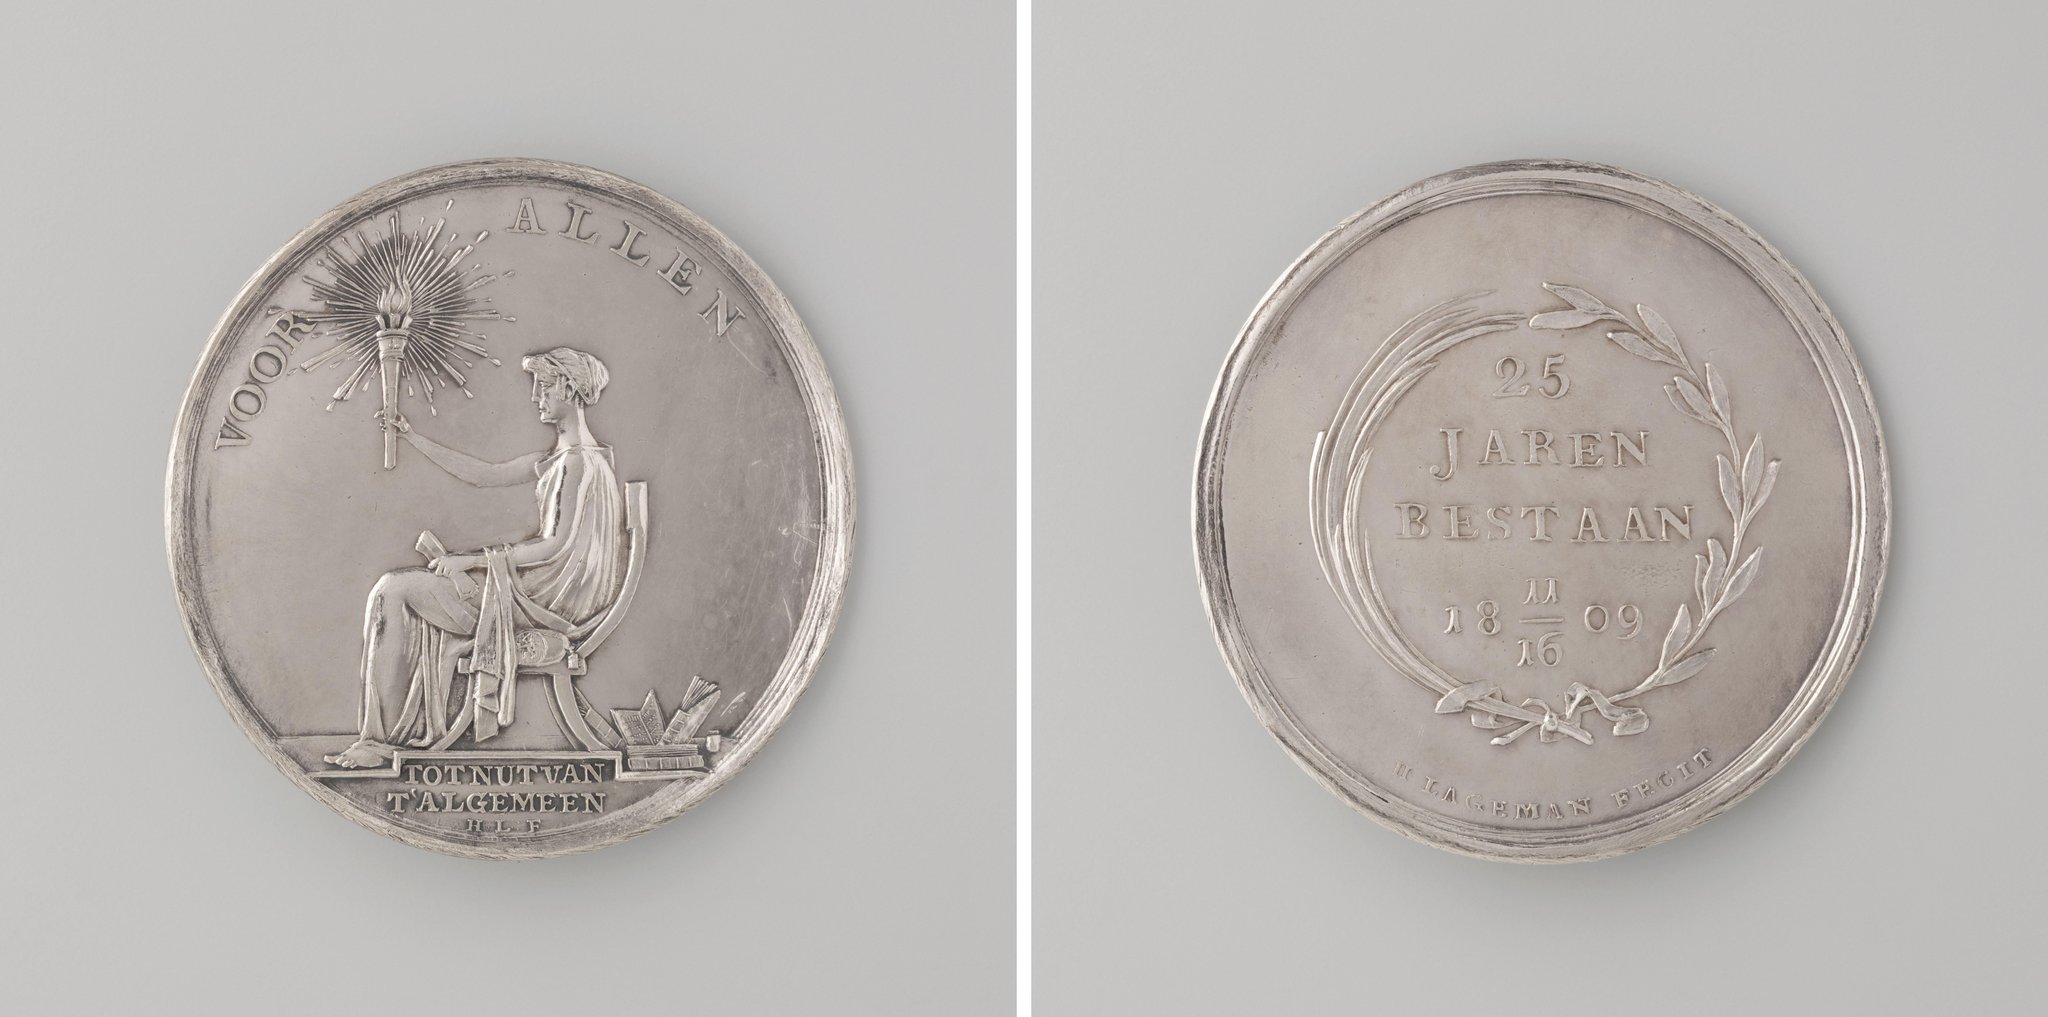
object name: history medal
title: Vijfentwintigjarig bestaan van de Maatschappij tot Nut van 't Algemeen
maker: hendrik lageman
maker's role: draughtsman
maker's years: 1765-1816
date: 1809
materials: silver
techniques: striking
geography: amsterdam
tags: maatschappij tot nut van 't algemeen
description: Zilveren penning. Voorzijde: vrouw zittend op stoel houdt brandende toorts in hand binnen omschrift; afsnede: opschrift. Keerzijde: opschrift binnen krans bestaande uit palm- en olijftak